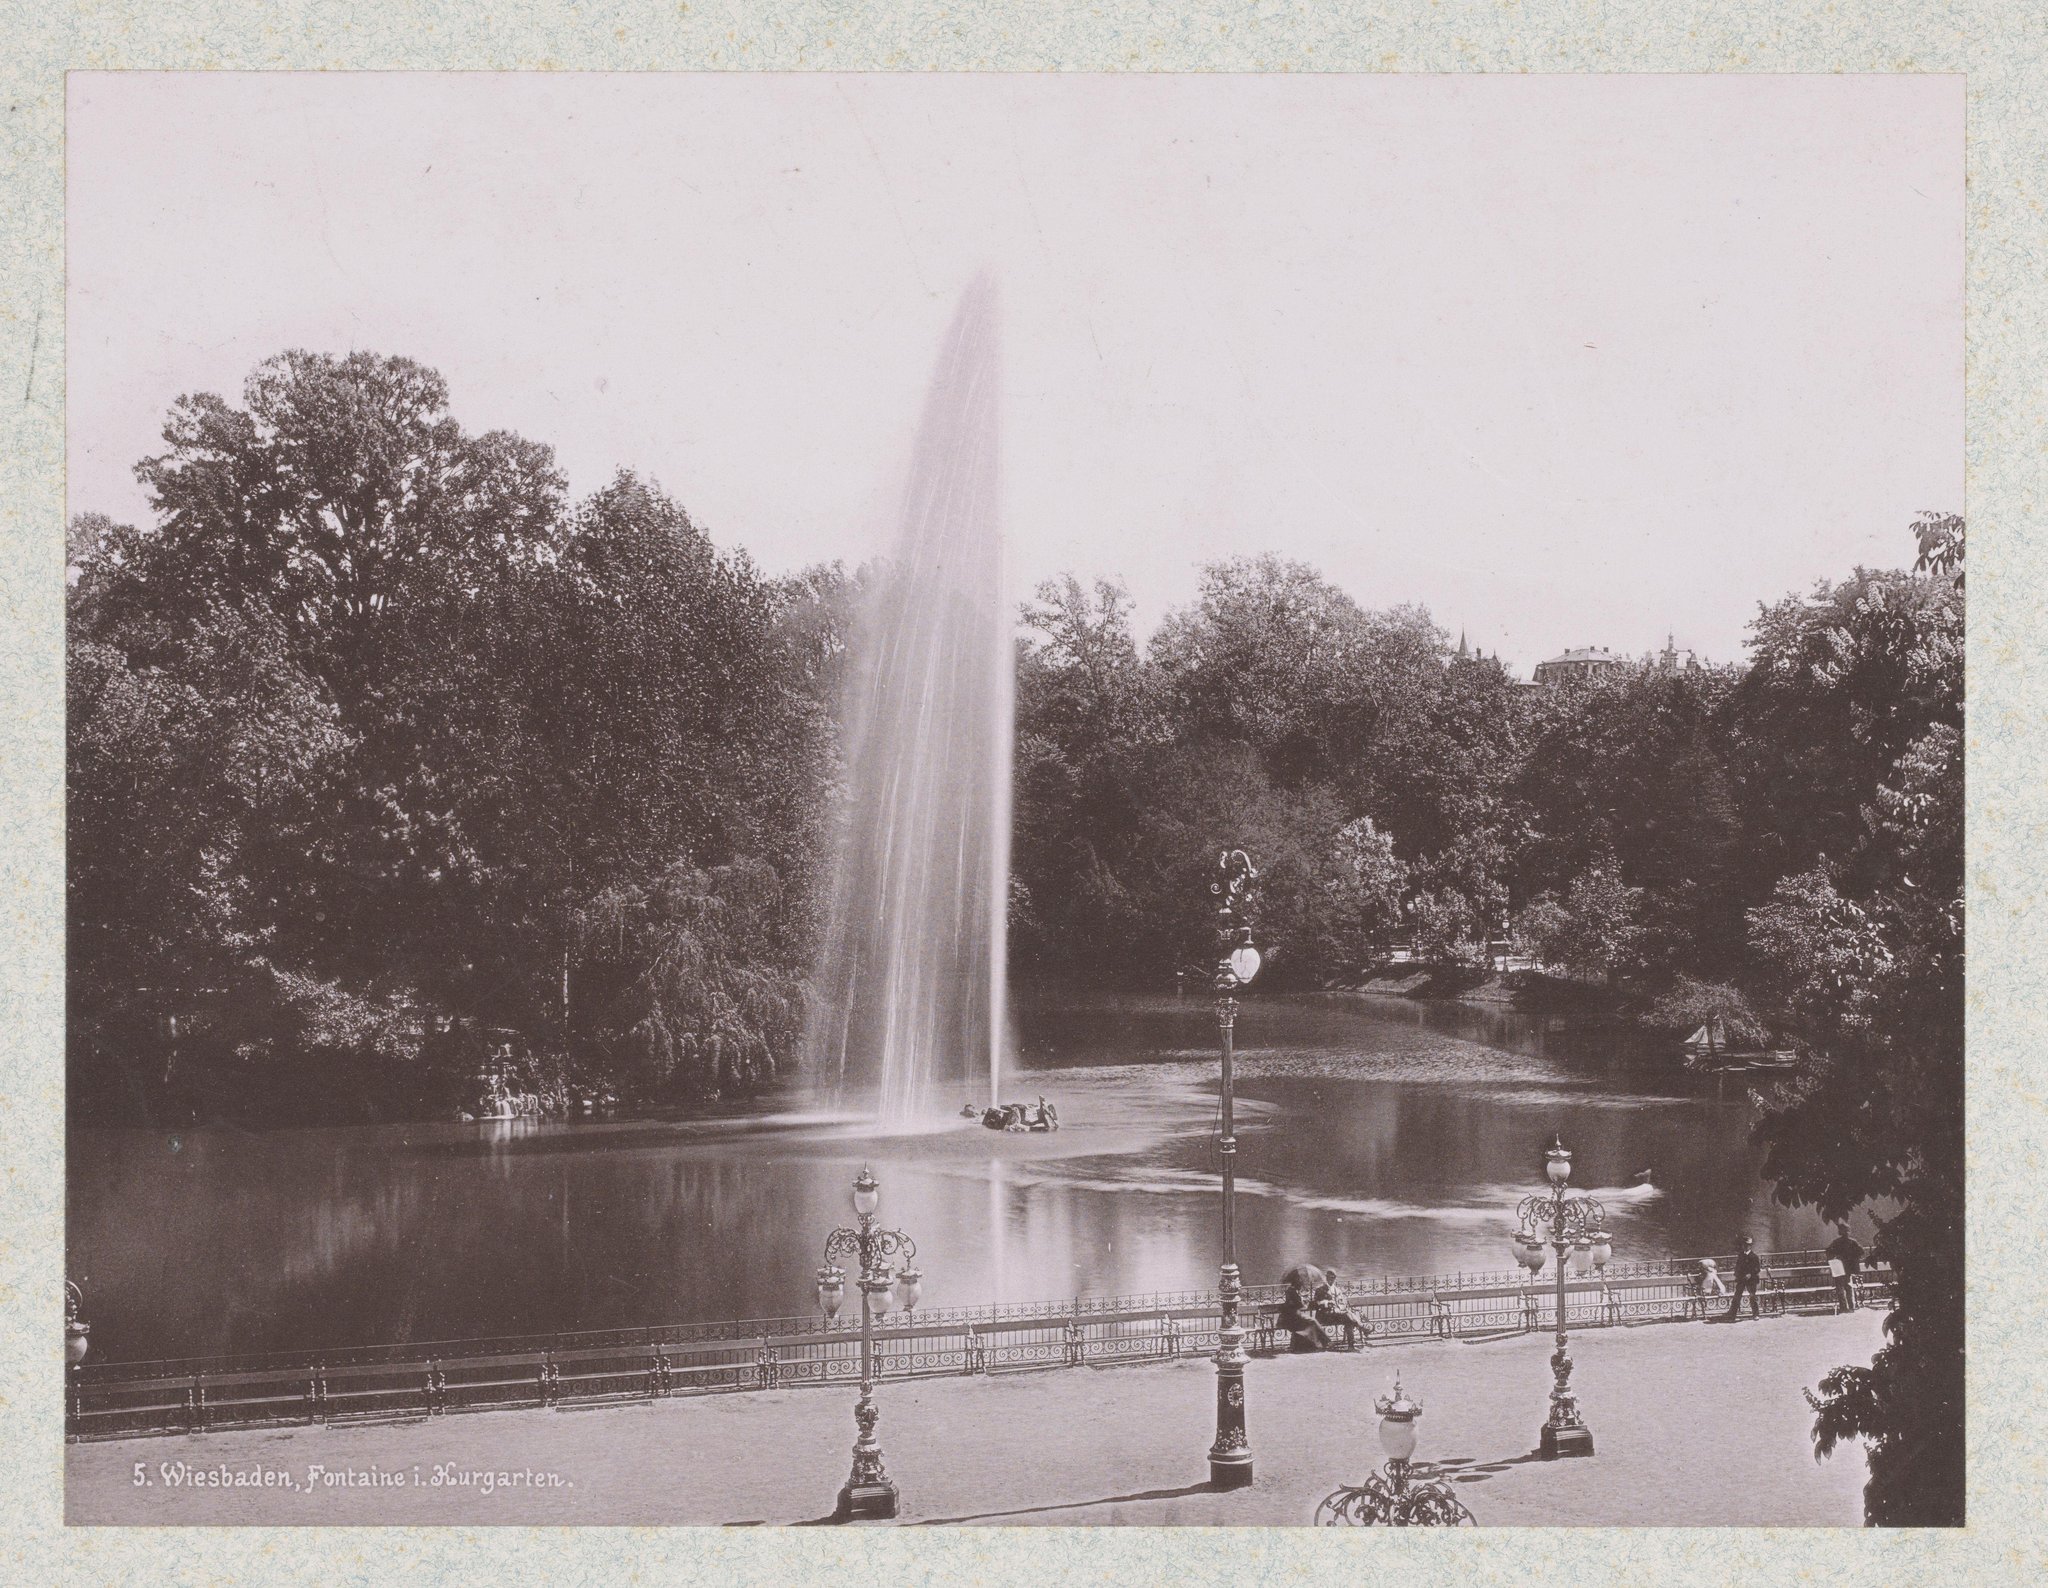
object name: photomechanical print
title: Kurgarten met fontein in Wiesbaden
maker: Anonymous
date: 1880-1900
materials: cardboard, paper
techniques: photograph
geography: wiesbaden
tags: ornamental fountain, public gardens, park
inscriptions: title: ‘5. Wiesbaden, Fontaine i. Kurgarten.’